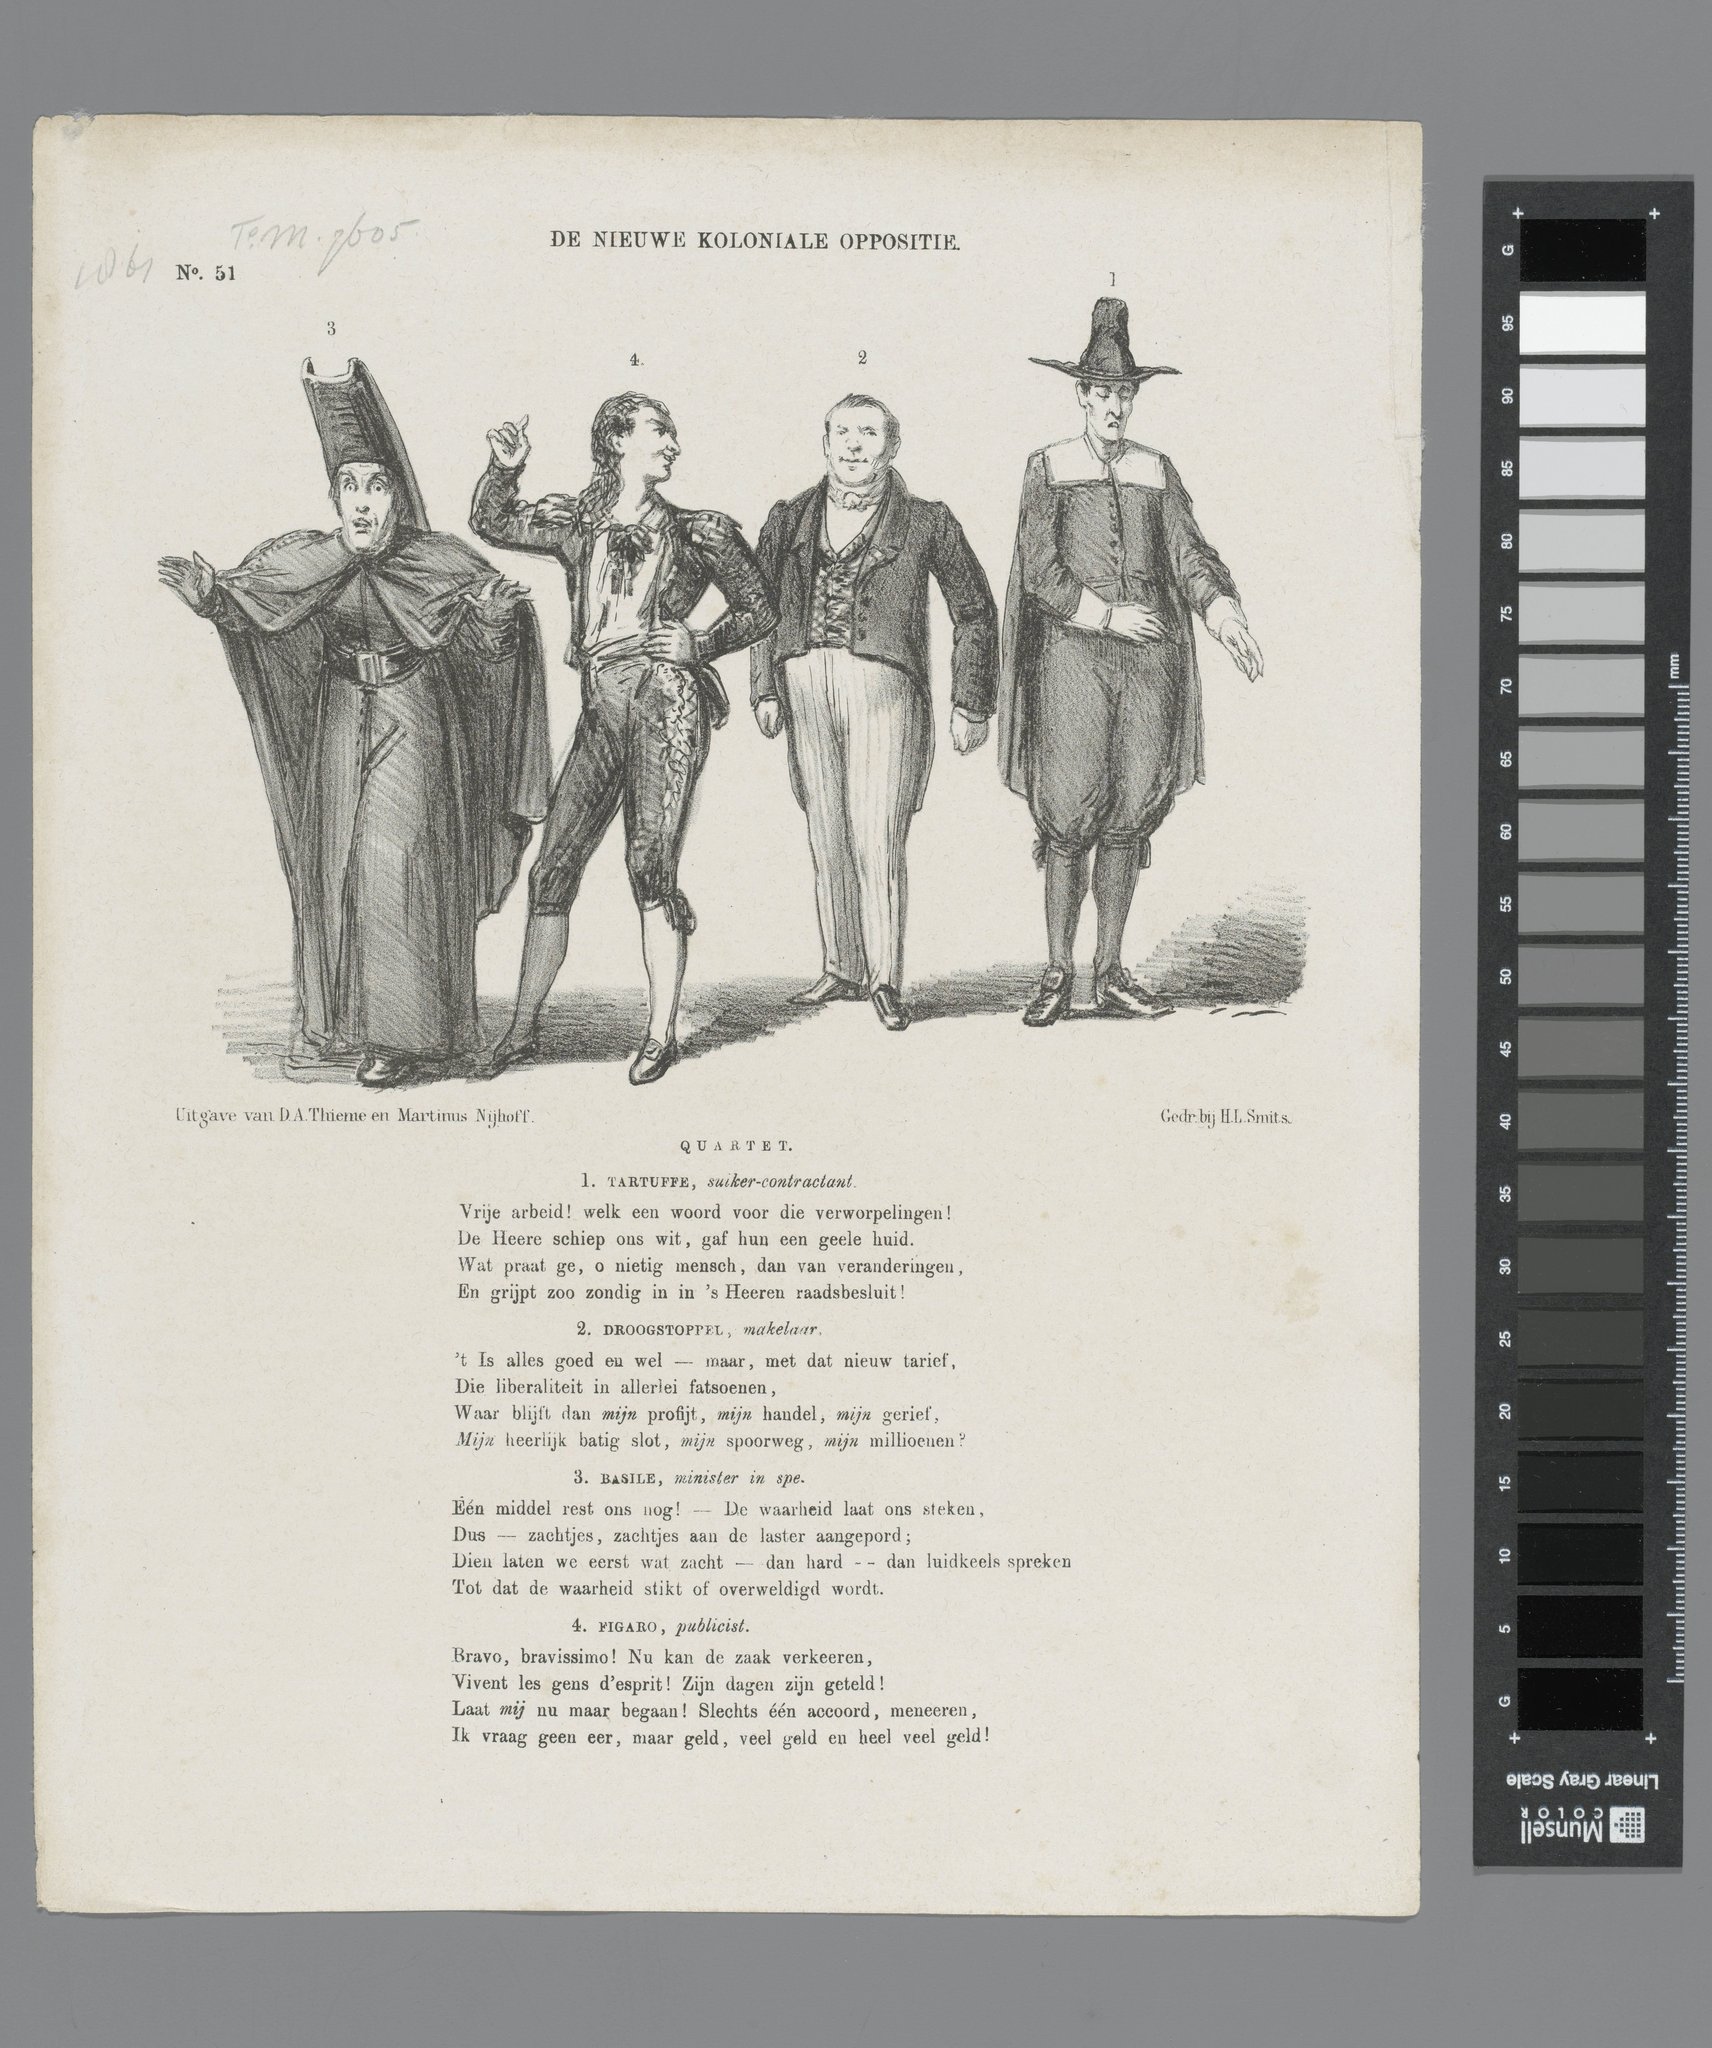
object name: cartoon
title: Spotprent op de koloniale oppositie, 1861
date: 1861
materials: paper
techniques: lithograph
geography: the hague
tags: literary characters and objects, dutch east indies, the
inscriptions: collector's mark: Lugt 2228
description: Spotprent op de nieuwe koloniale oppositie. Vier staande figuren: Tartuffe, Droogstoppel, Basile en Figaro. Onderaan een vers door elk van de voorgestelde figuren. Plaat verschenen bij het weekblad De Nederlandsche Spectator, nr. 51, 21 december 1861.